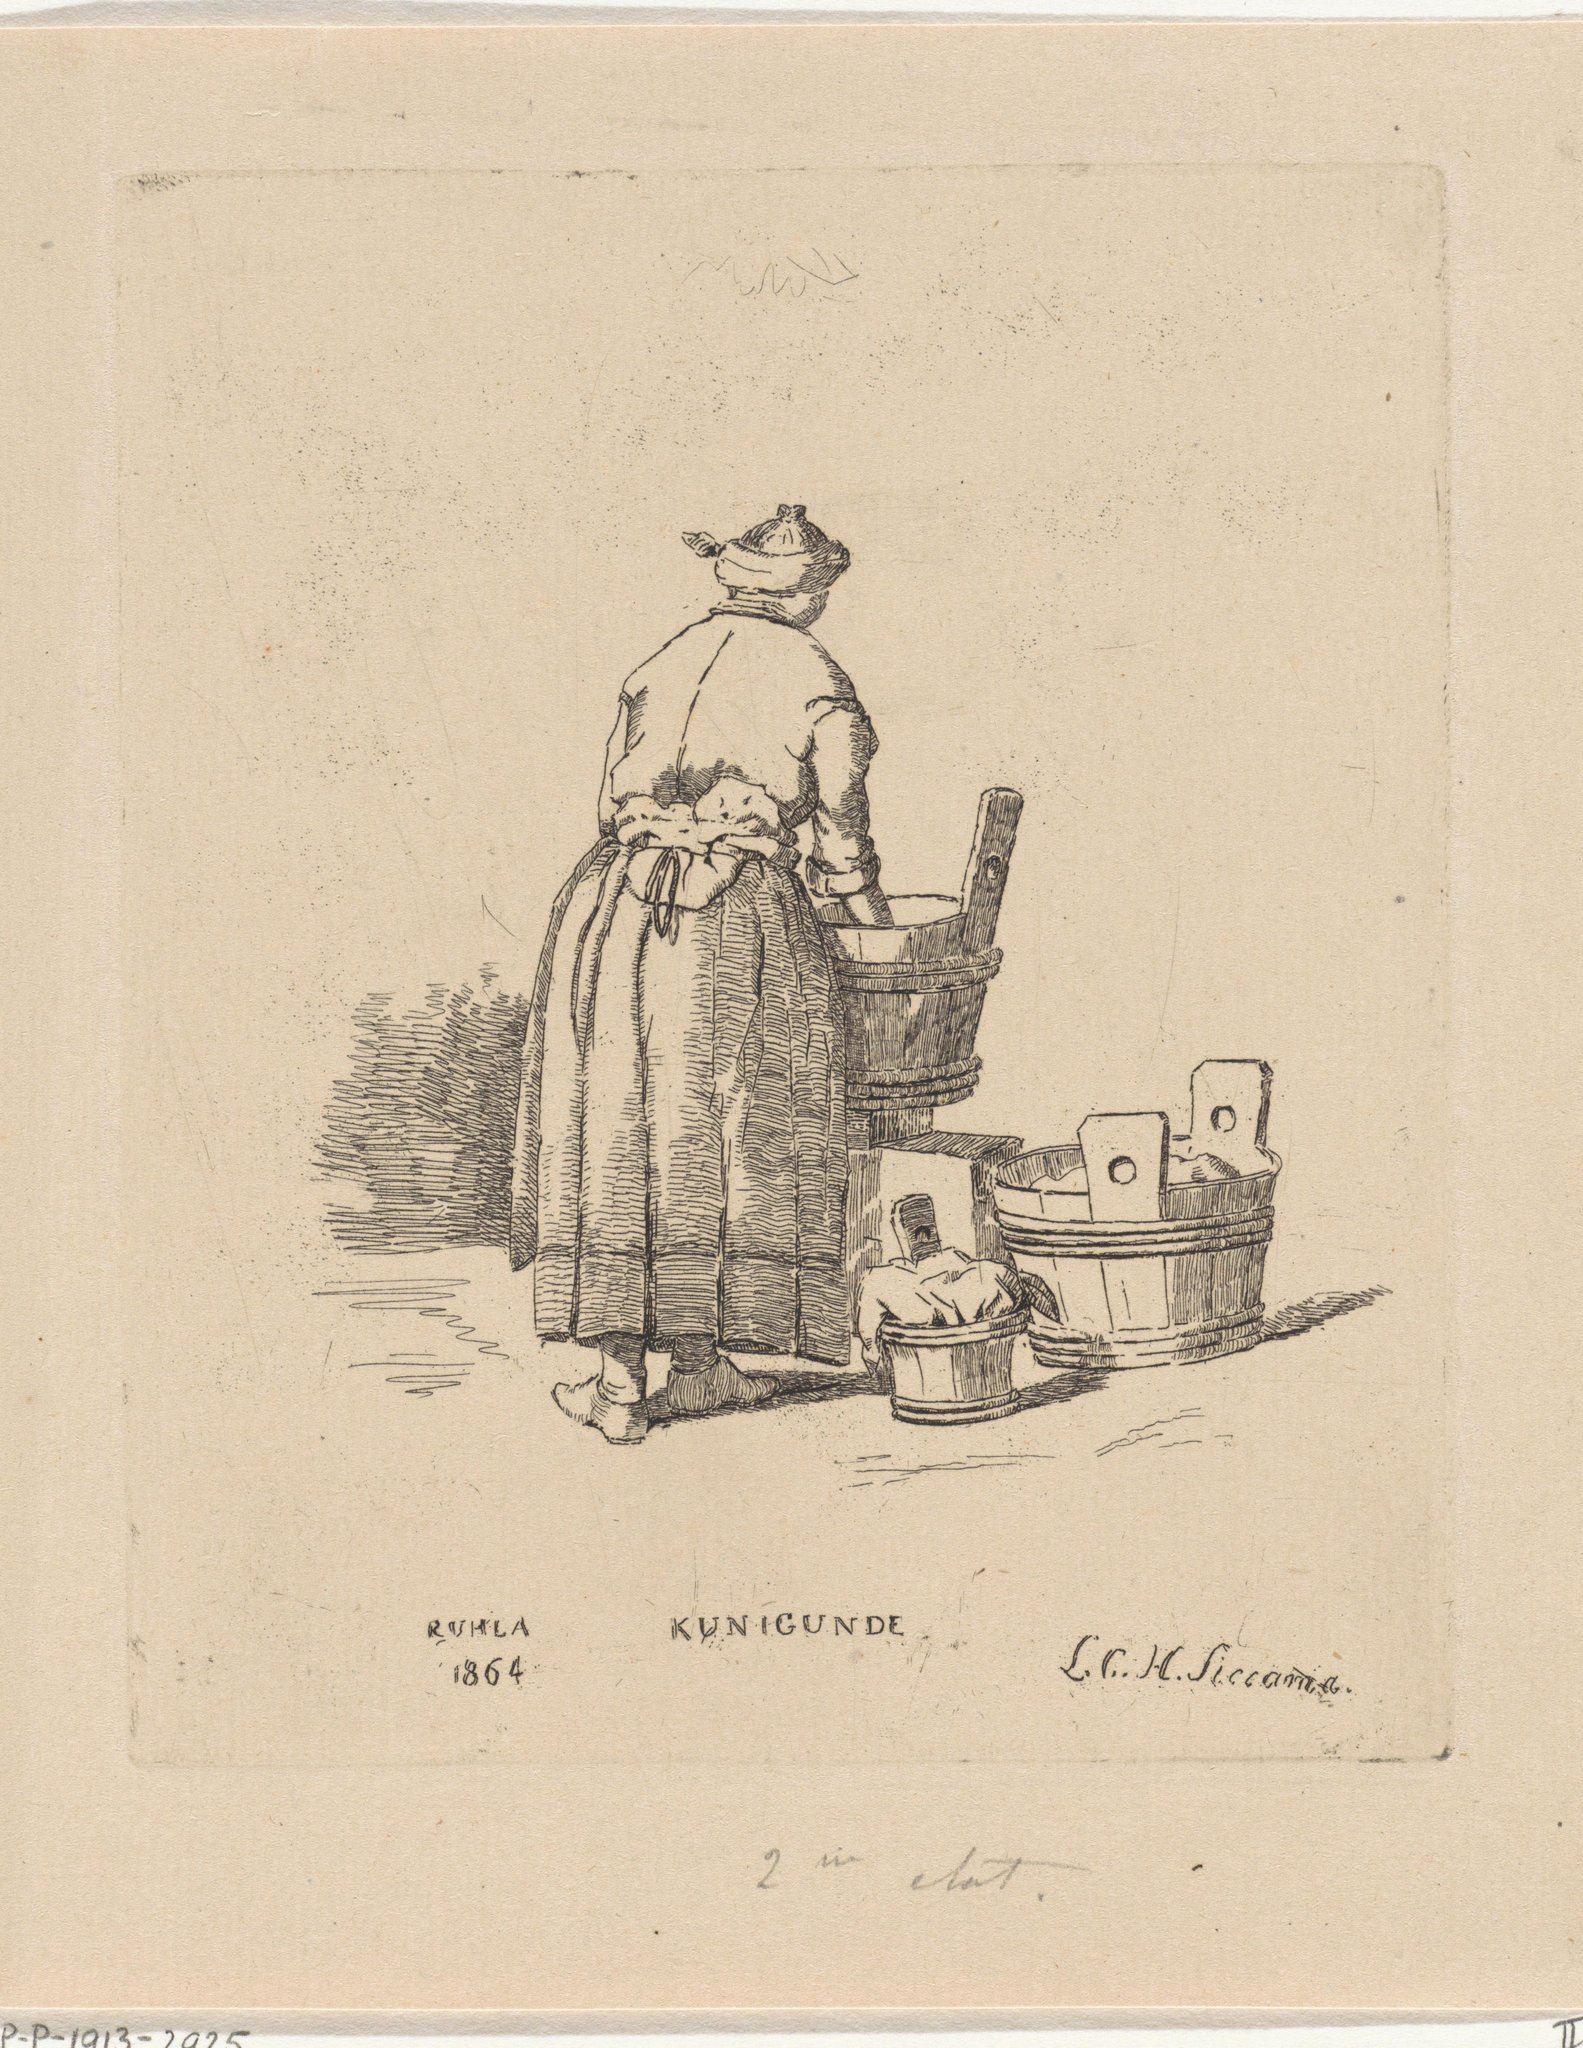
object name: print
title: Kunigunde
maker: louis charles hora siccama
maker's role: draughtsman, print maker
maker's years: 1807-1880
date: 1864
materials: paper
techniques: etching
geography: utrecht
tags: wash house, home laundry, laundry room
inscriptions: inscription: ‘2me etat’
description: Een vrouw doet de was in een grote tobbe. Een tweede tobbe staat naast haar op de grond. Daarnaast een kleinere tobbe met wasgoed.